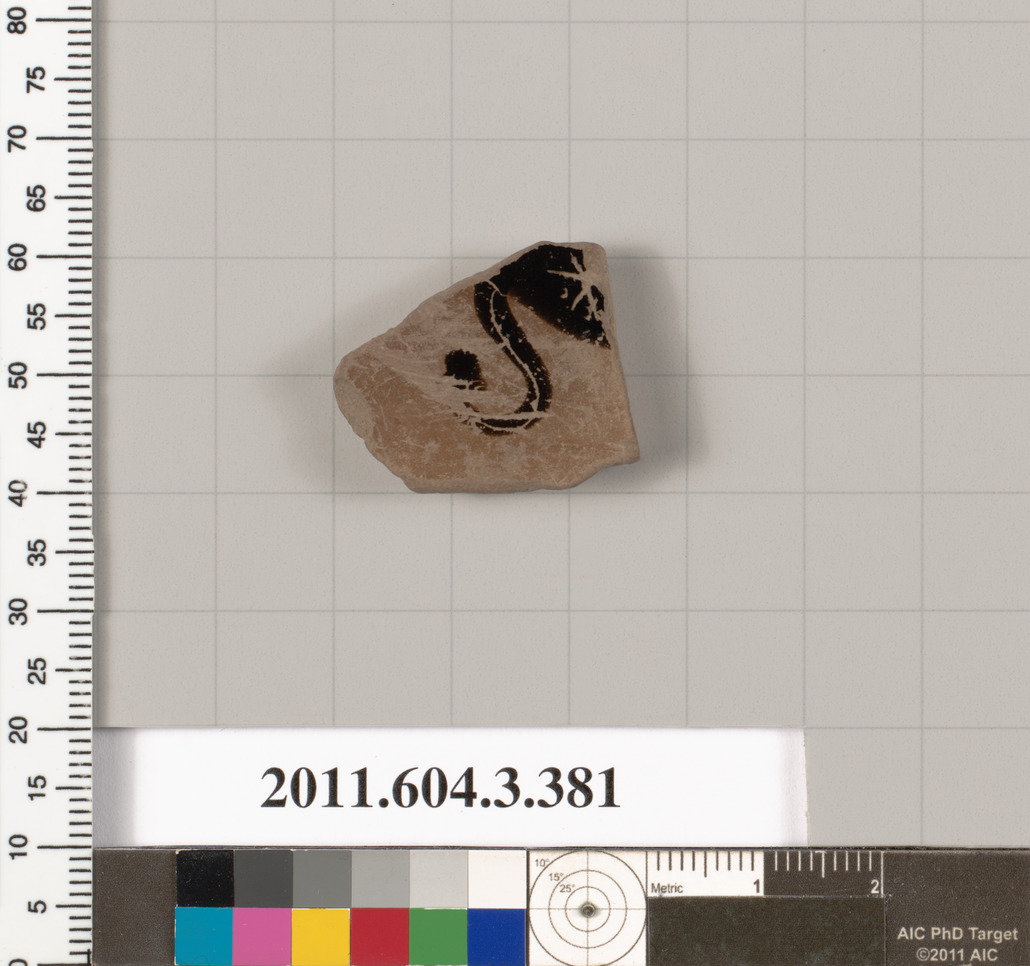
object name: neck amphora fragment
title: Terracotta fragment of a neck-amphora (jar)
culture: greek, attic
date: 534-501 BCE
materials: terracotta